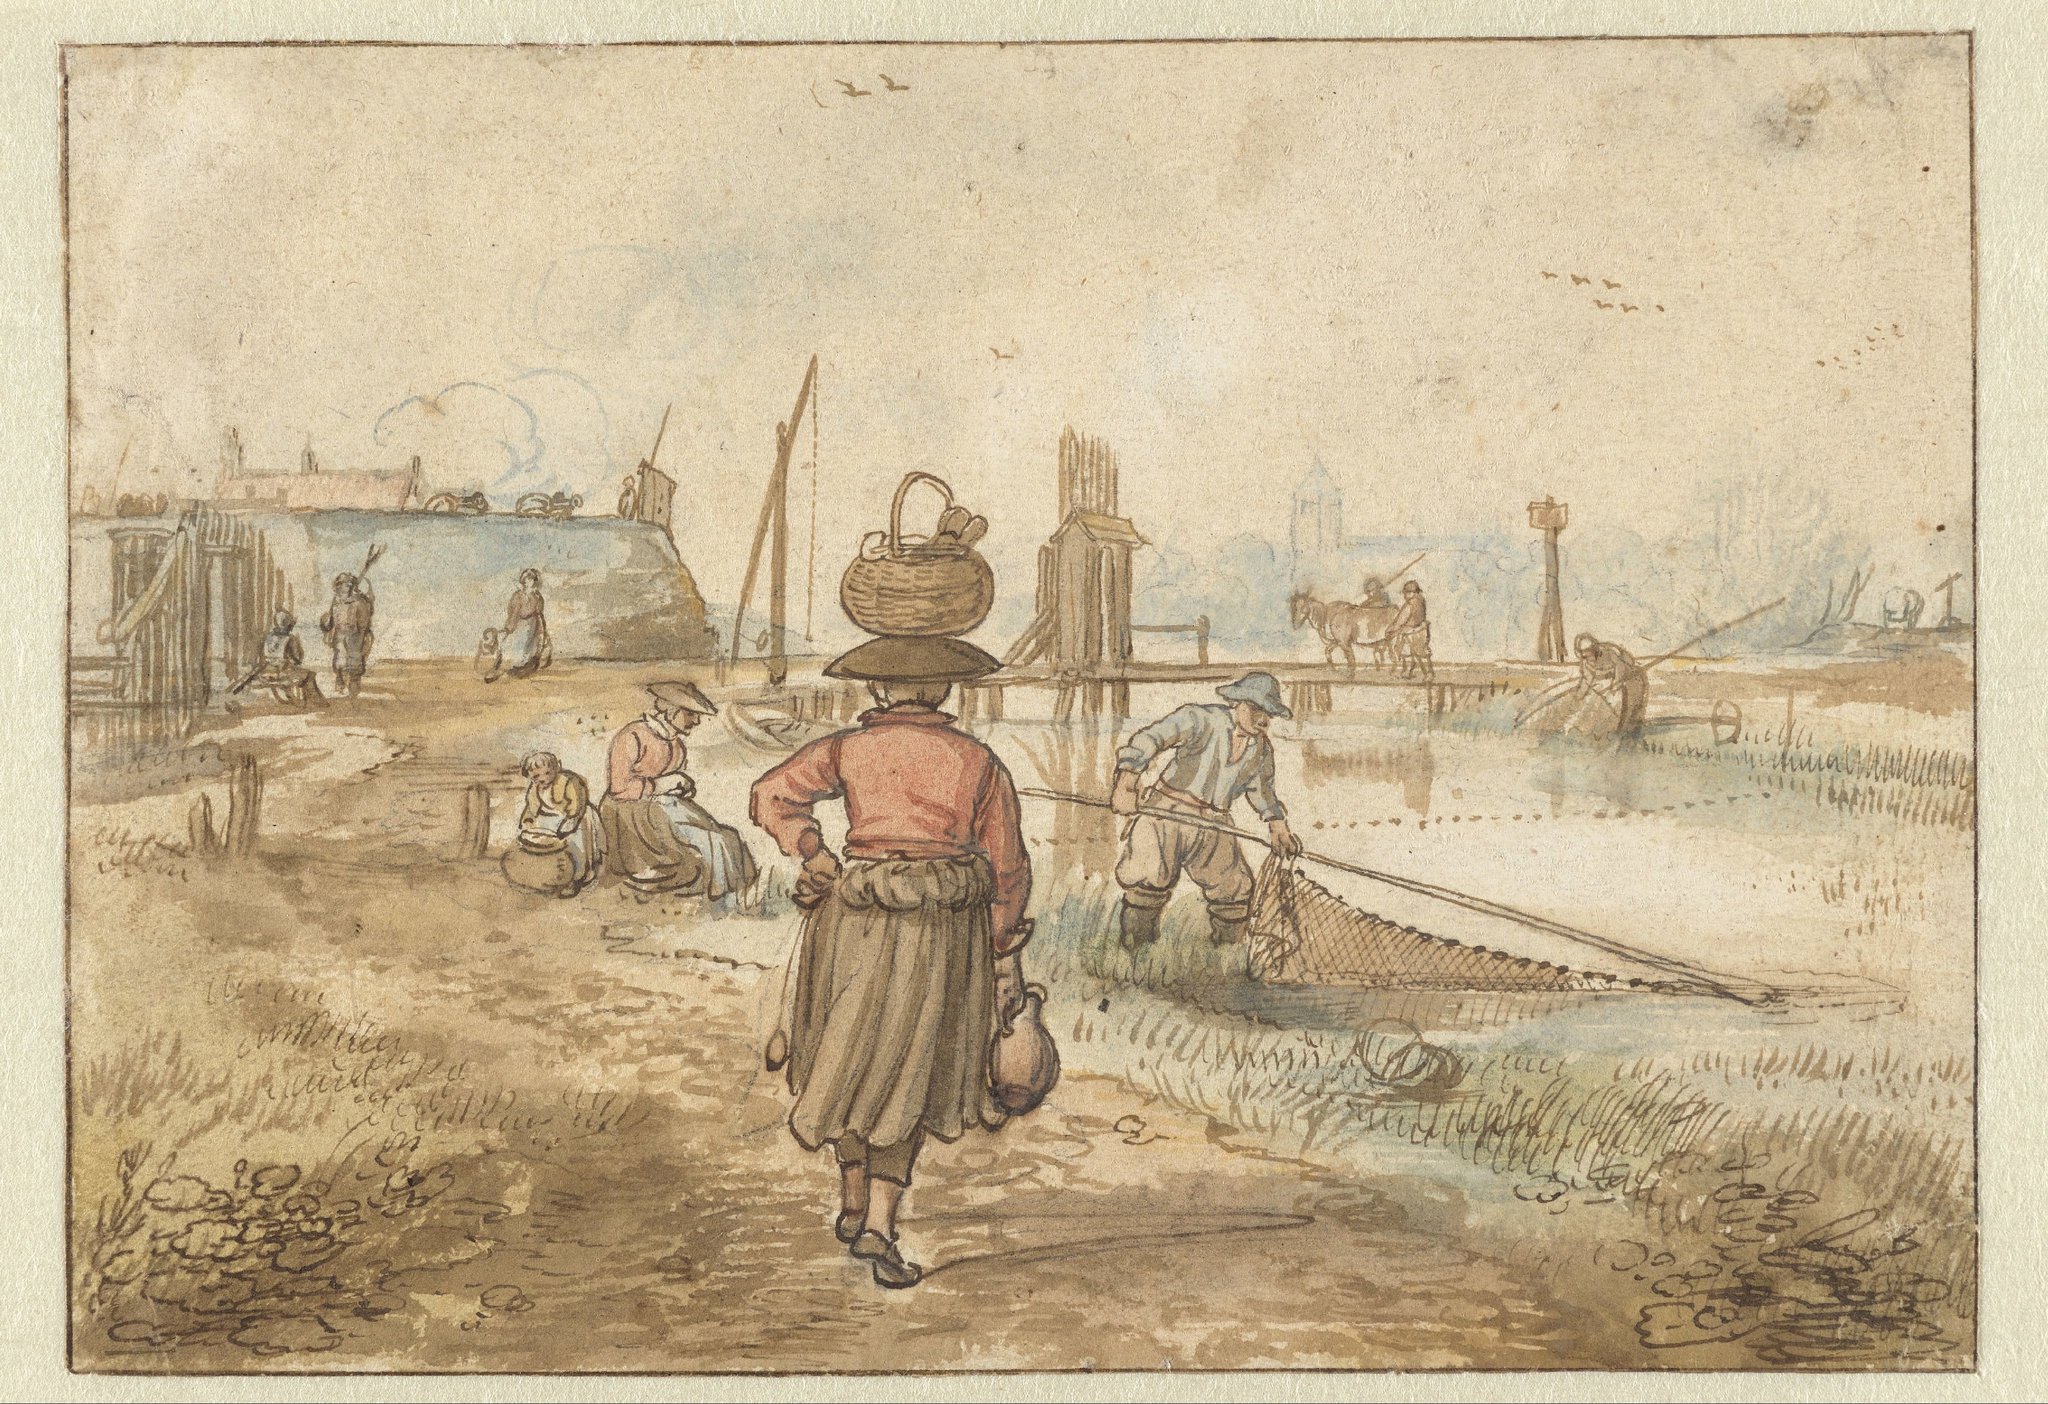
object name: drawing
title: River Landscape with a Woman Carrying a Basket on her Head, Fishermen and Other Figures near the Walls of a Town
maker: hendrick avercamp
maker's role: draughtsman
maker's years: 1585-1634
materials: chalk, paint, graphite, ink, paper, watercolor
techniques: brush, pen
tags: fresh-water fishery, outskirts of city (+ city (-scape) with figures, staffage), city-walls, carrying something on the head or on the shoulders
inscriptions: date: ‘omtrent A.o 1620’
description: Vissers in het water van een stadsgracht; op de voorgrond loopt een vrouw die een mand op haar hoofd draagt, op de rug gezien.